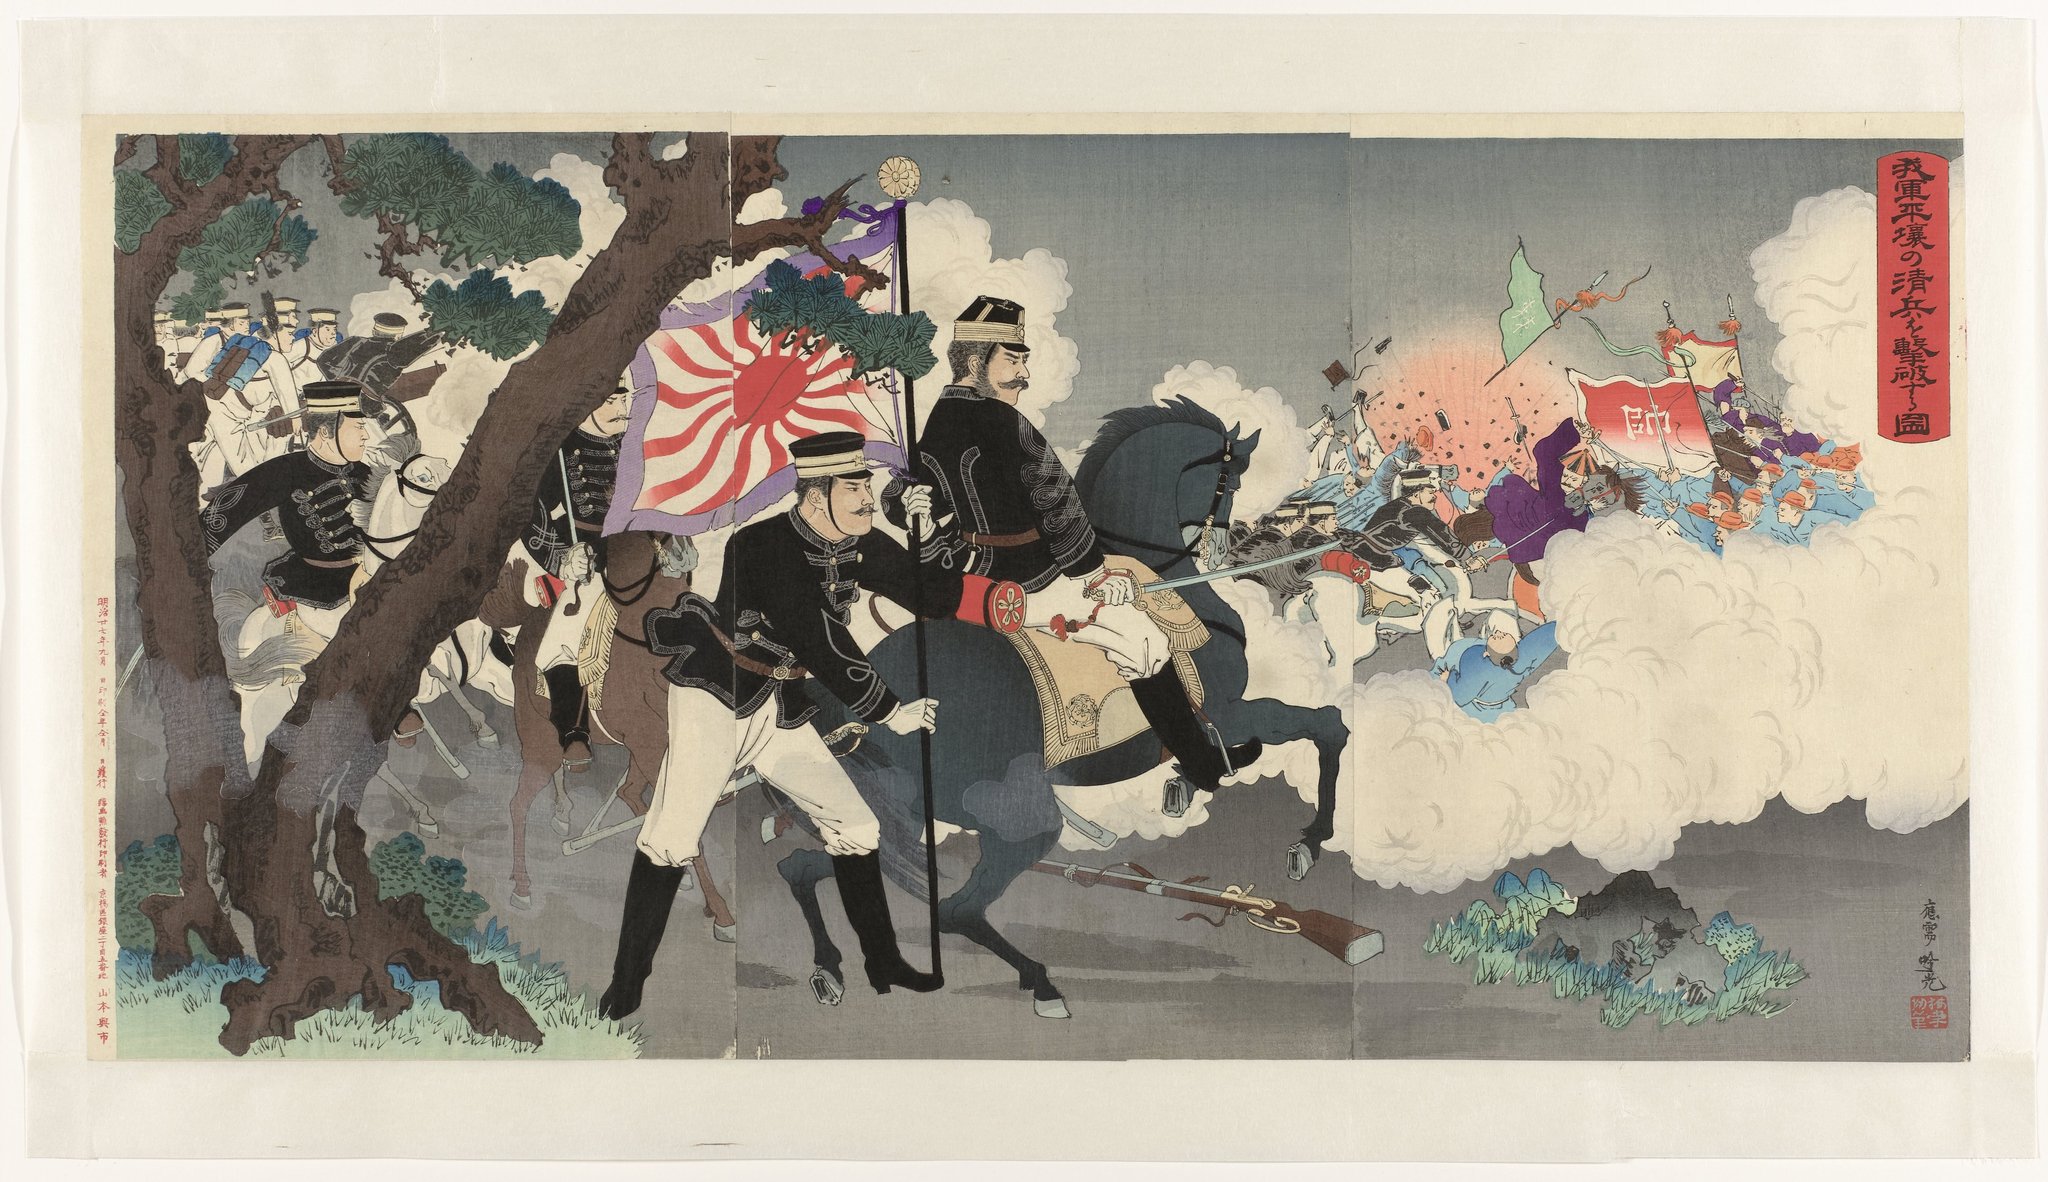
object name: print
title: Afbeelding van ons leger dat de Chinezen verslaat bij Pyongyang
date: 1894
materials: paper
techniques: woodcut, polish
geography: japan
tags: riding a horse, ass, or mule; rider, horseman, battle, officer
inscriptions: label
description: Japanse officieren te paard en soldaten gaan de strijd aan met het Chinese leger nabij de stad Pyongyang. De slag om Pyongyang eindigde op 16 september 1894, tijdens de Eerste Chinees-Japanse Oorlog.